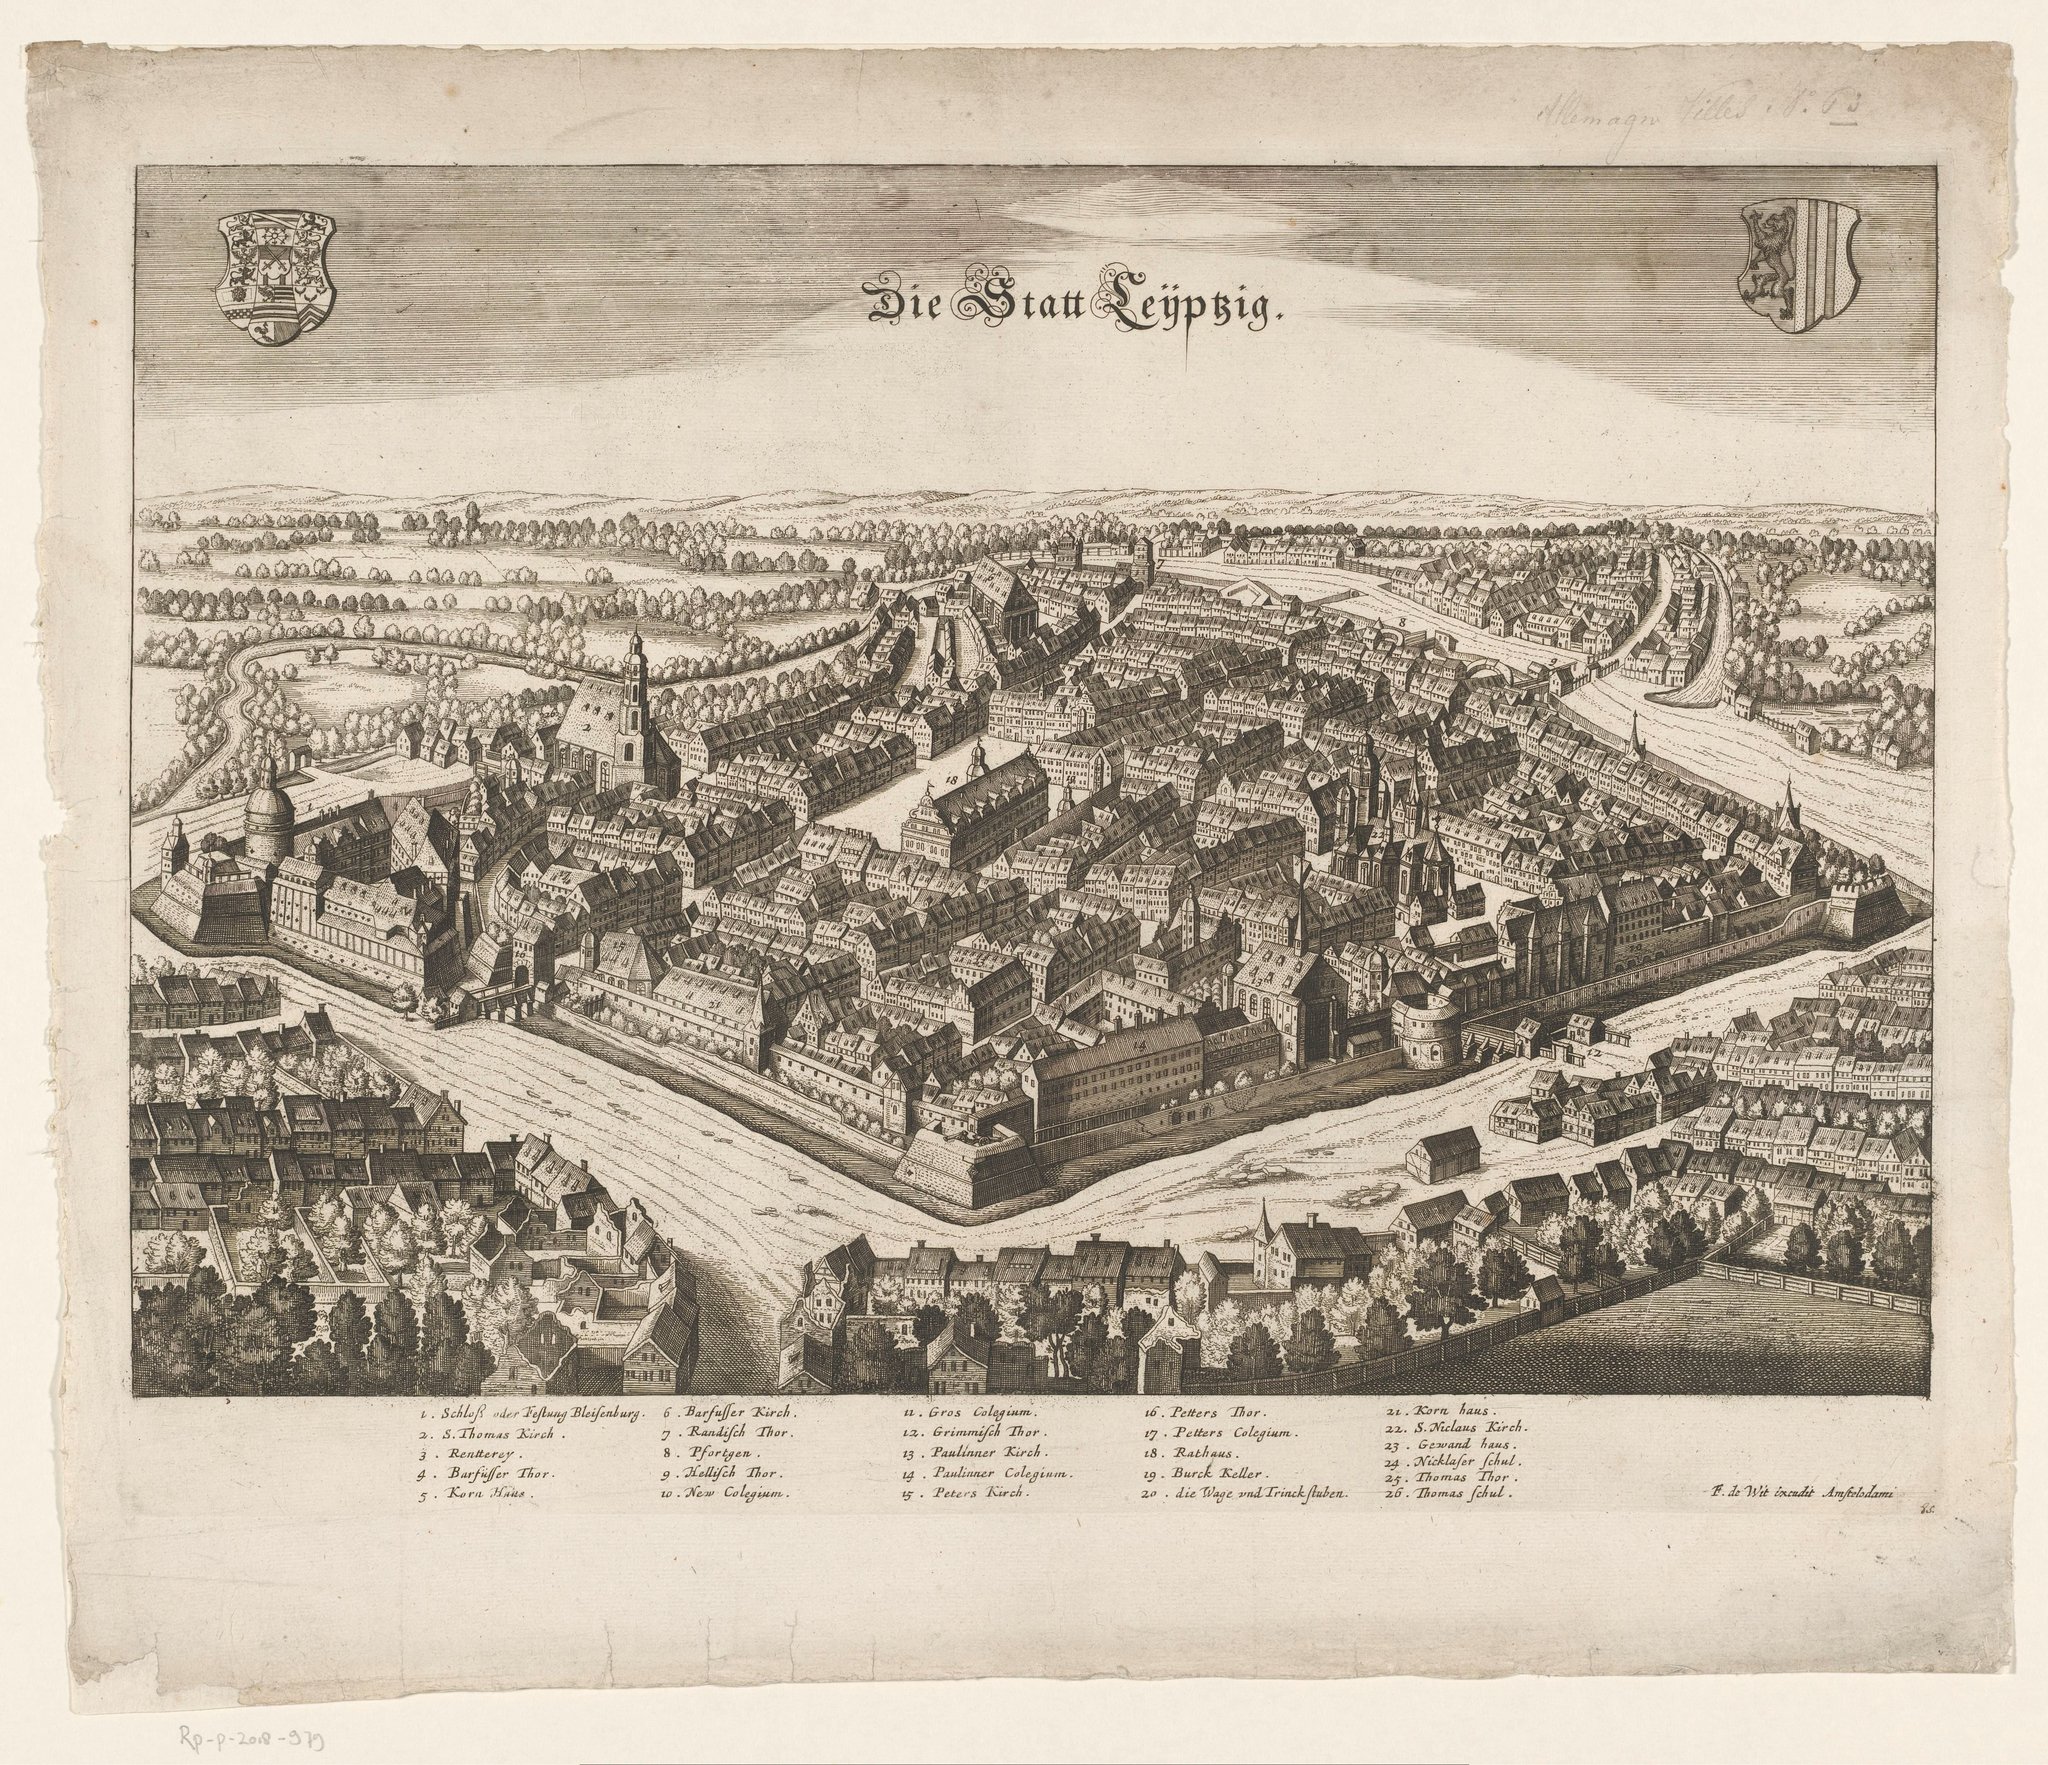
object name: print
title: Die statt Leijptzig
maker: Anonymous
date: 1657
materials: paper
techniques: engraving, etching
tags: coat of arms (as symbol of the state, etc.) (+ city; municipal), prospect of city, town panorama, silhouette of city, armorial bearing, heraldry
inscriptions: collector's mark: Lugt 2228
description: Gezicht op Leipzig in vogelvlucht perspectief. Linksboven een familiewapen. Rechtsboven het wapen van Leipzig.